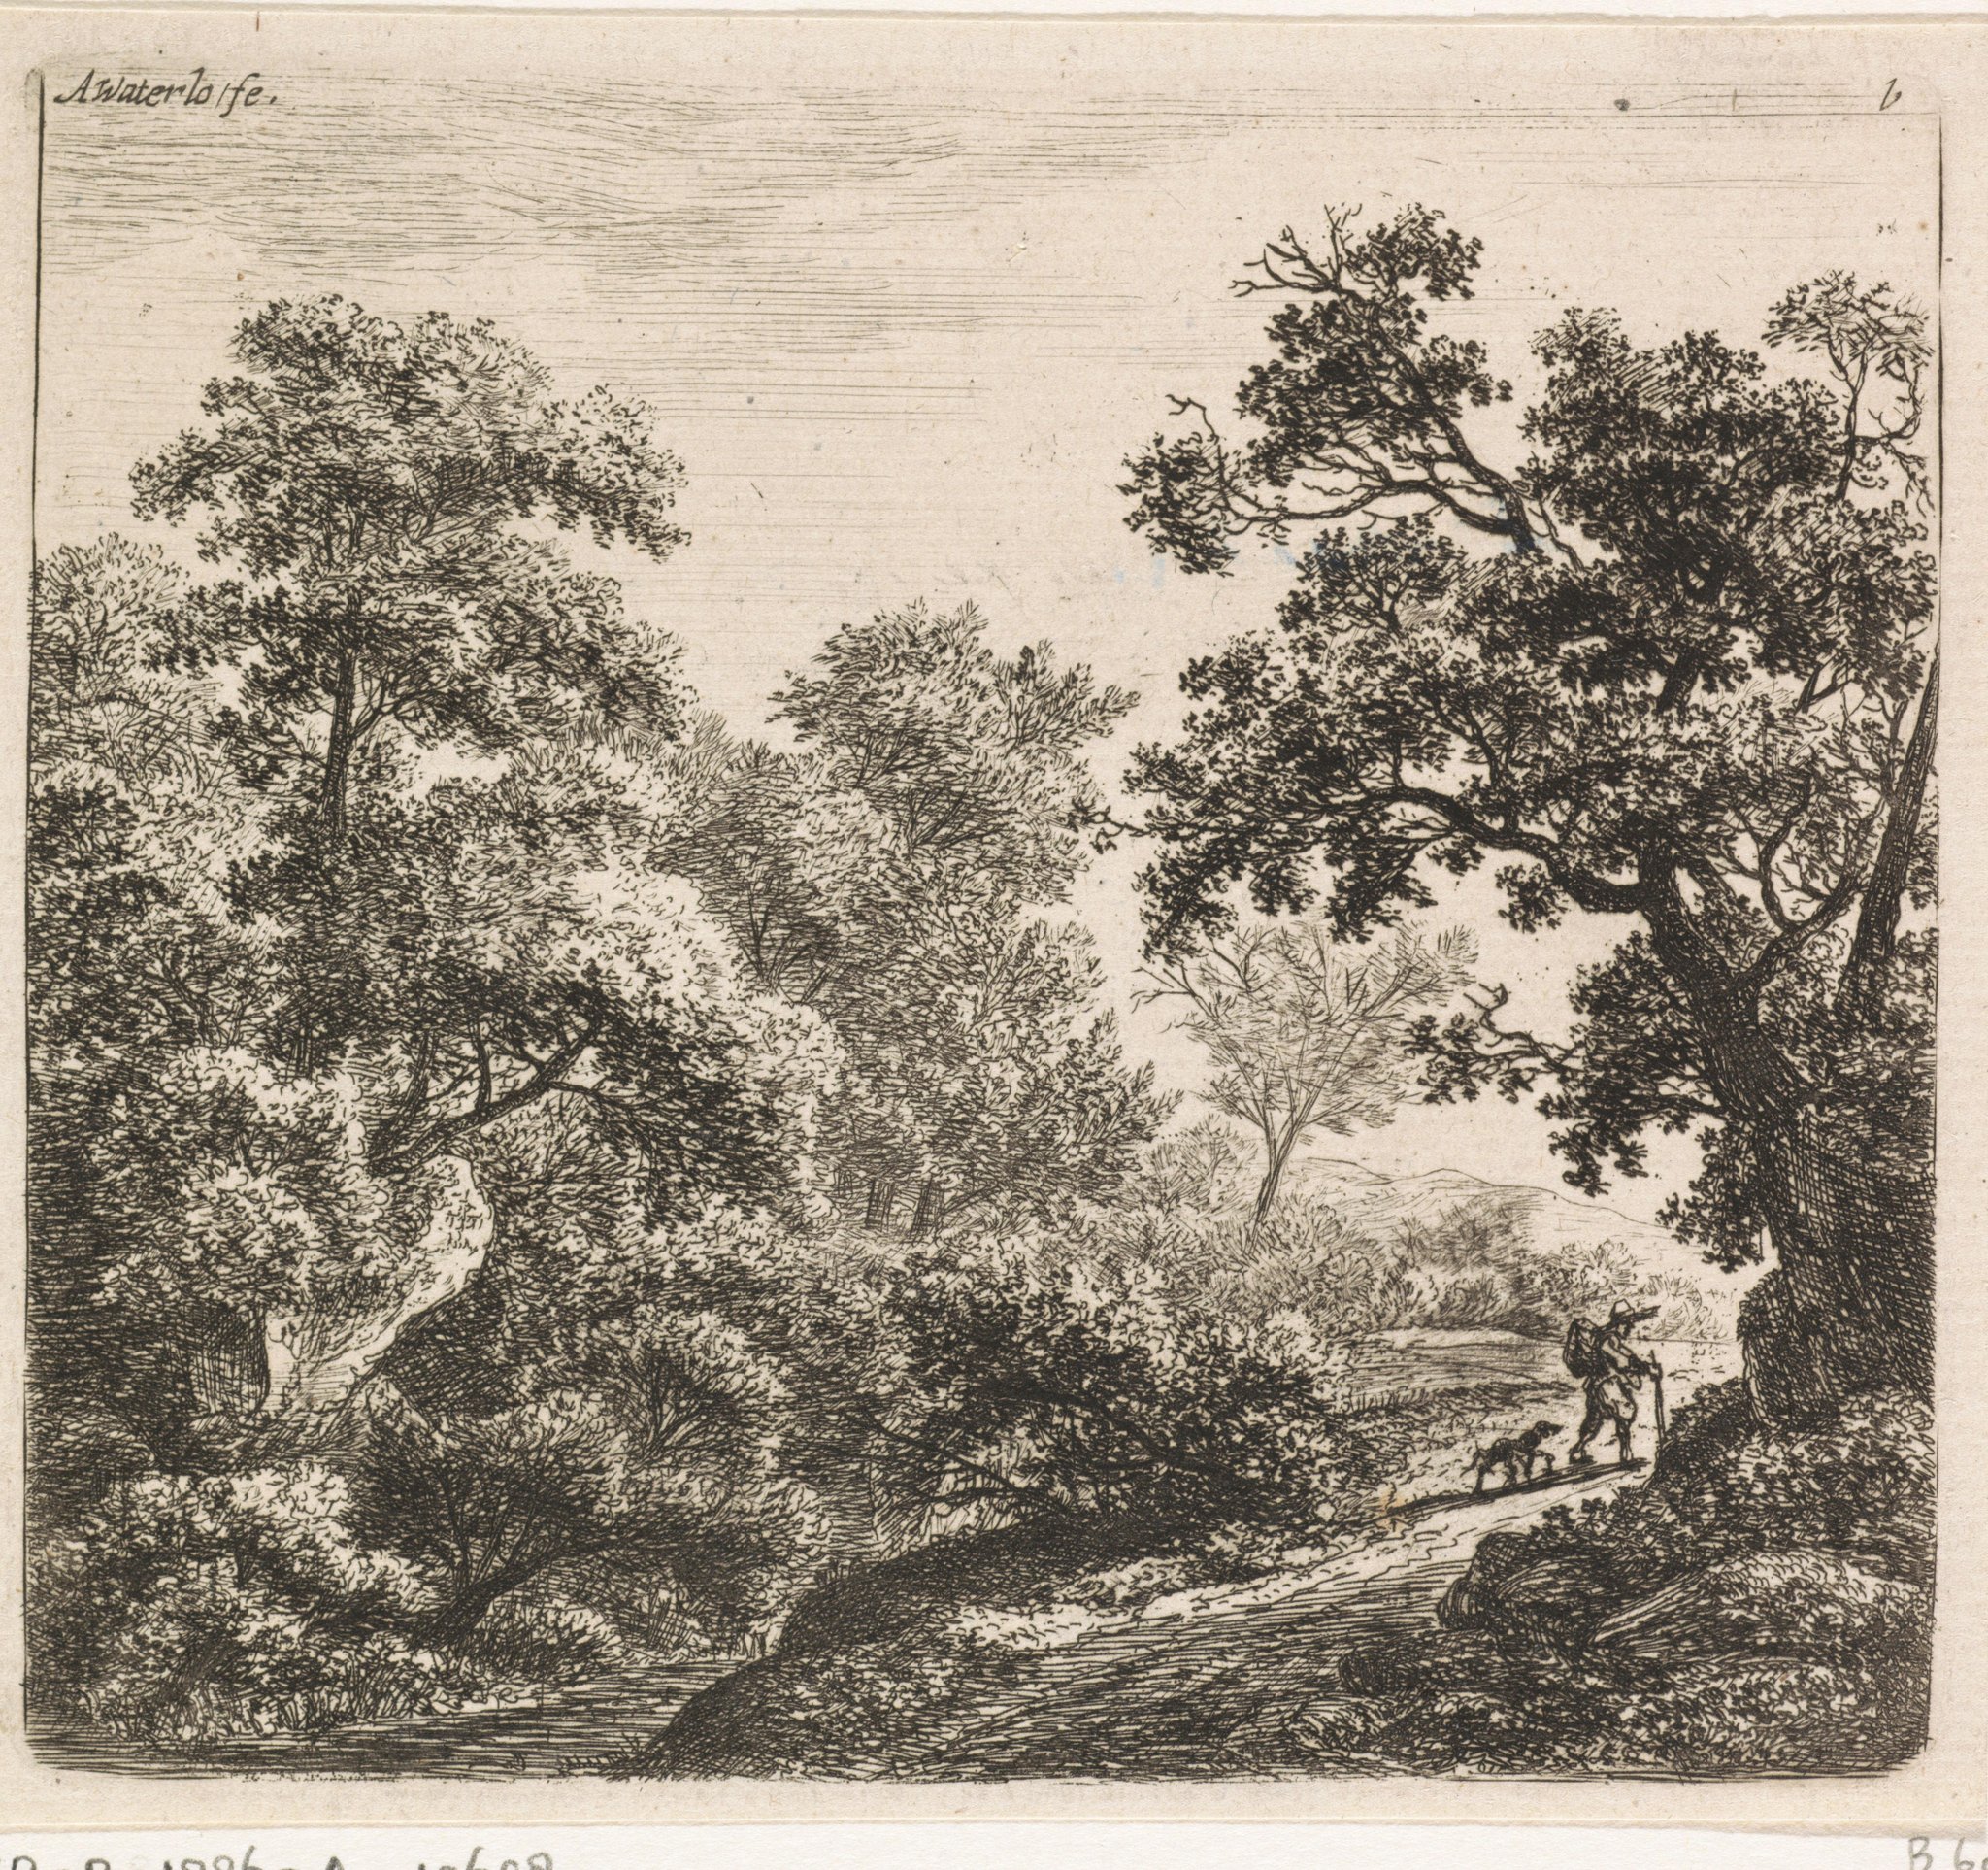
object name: print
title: Beboste landschappen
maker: anthonie waterloo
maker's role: draughtsman, painter, print maker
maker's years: 1609-1690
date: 1630-1663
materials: paper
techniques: etching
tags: forest, wood, brook, 'en route', traveller under way, dog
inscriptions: collector's mark: Lugt 2228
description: In een heuvelachtig, bebost landschap loopt rechts een reiziger met een hond. Links stroomt een beek. Rechtsboven is de letter b te zien.